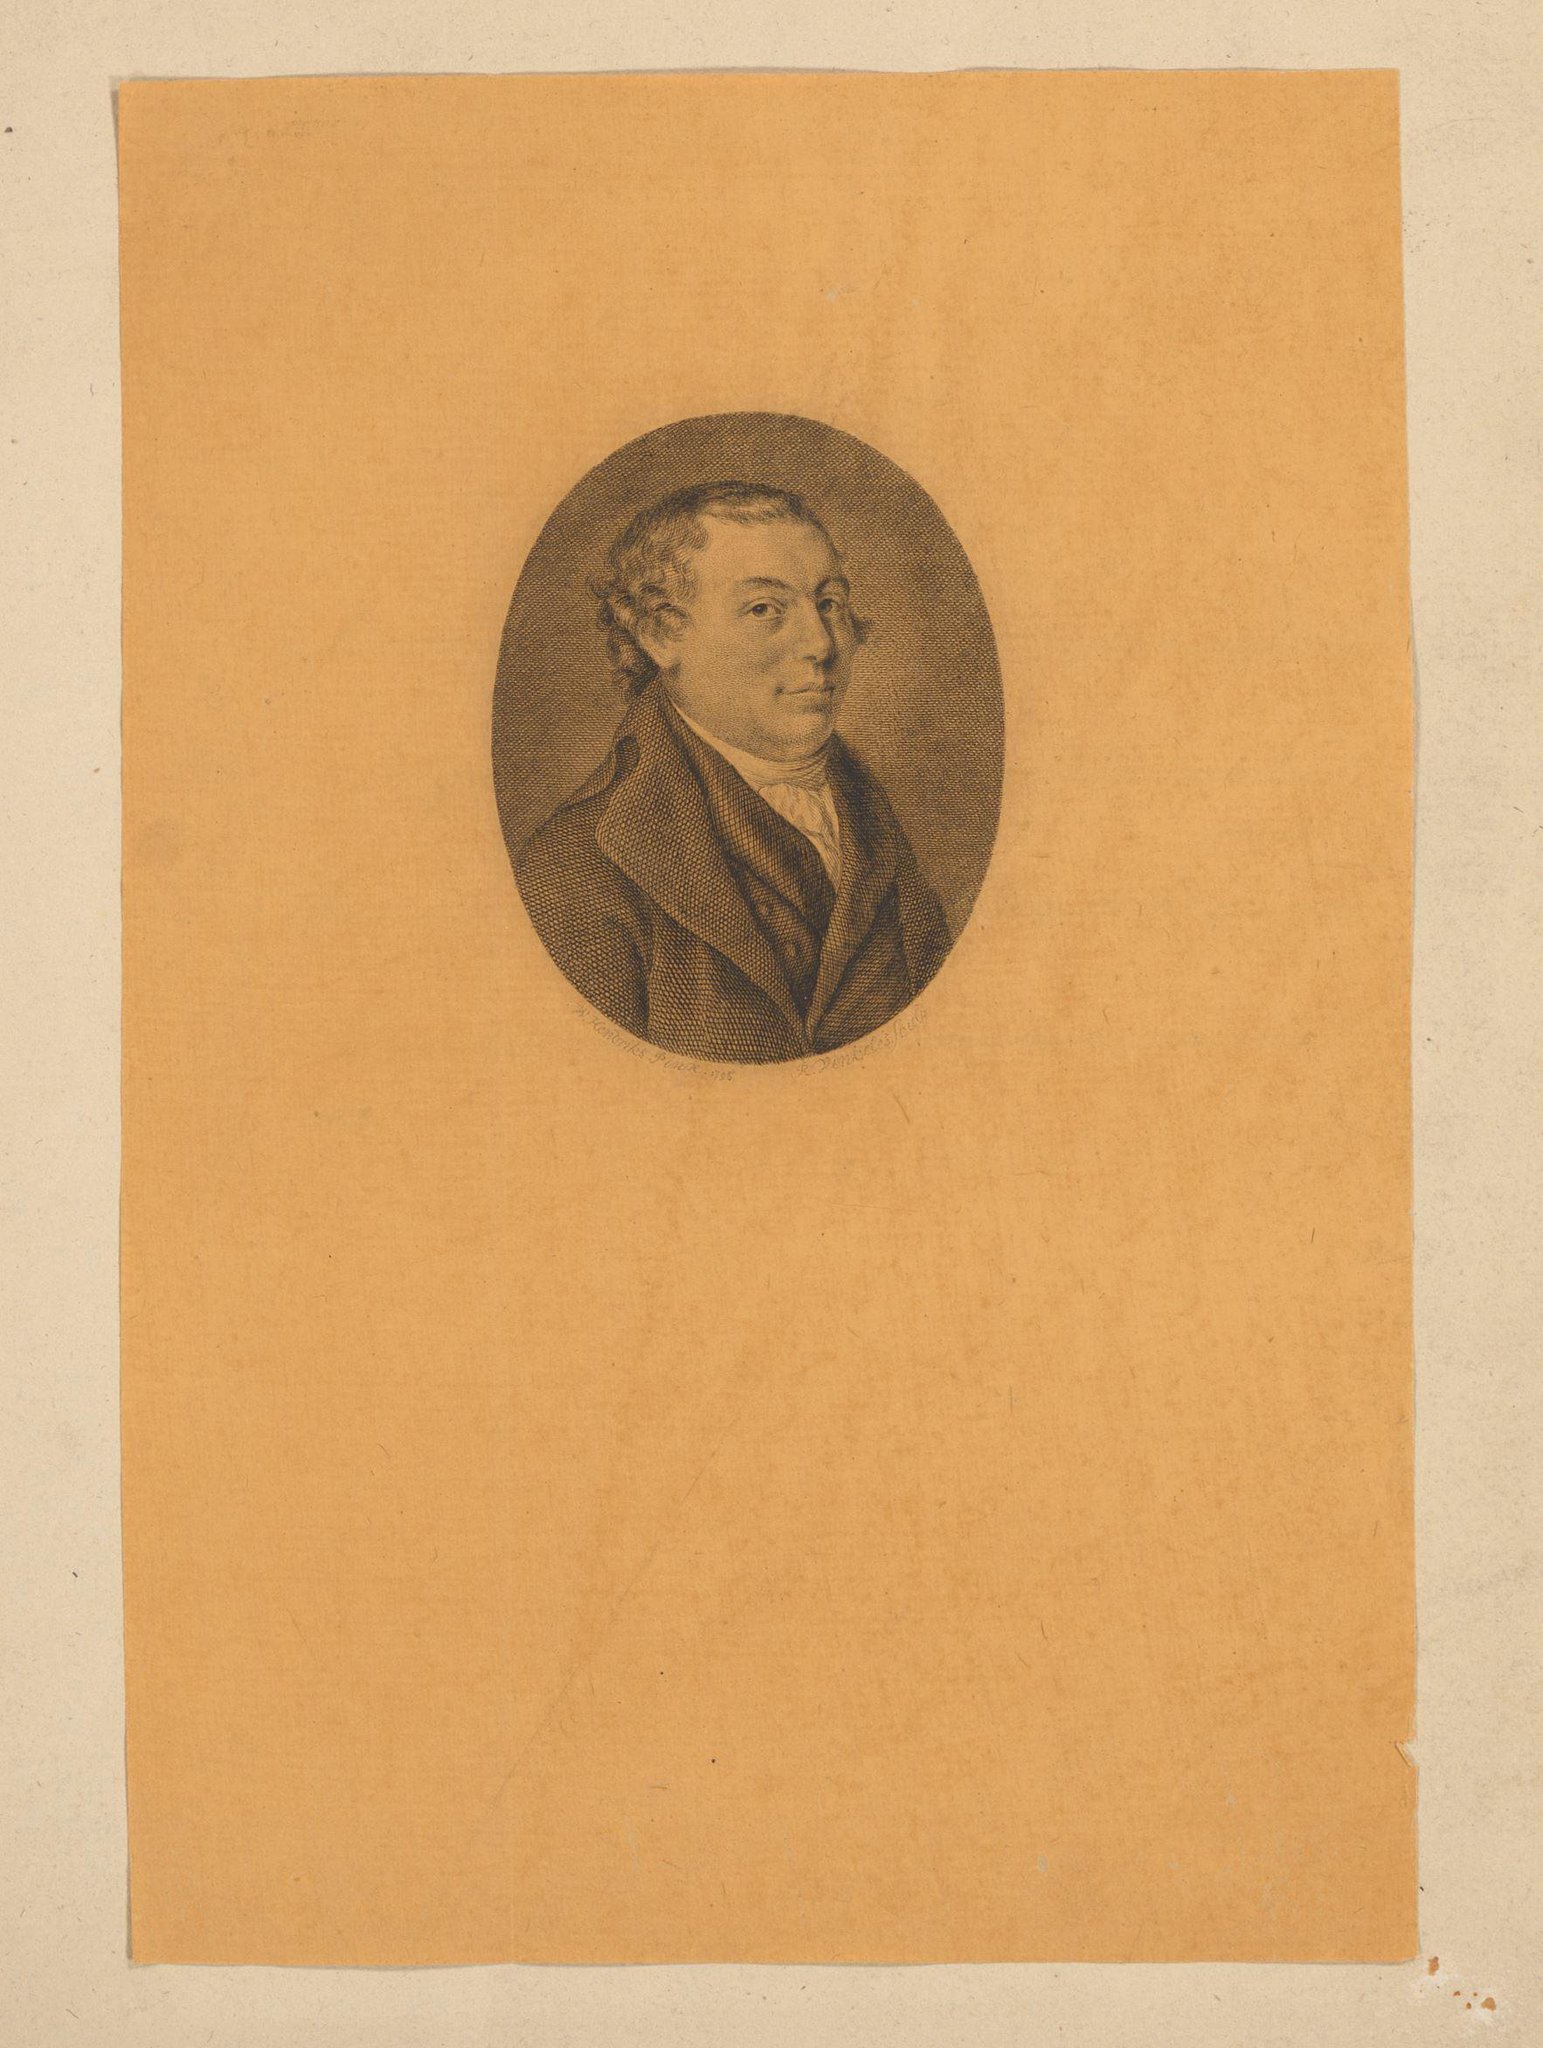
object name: album leaf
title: Portret van Adriaan Pietersz. Loosjes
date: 1796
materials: paper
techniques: engraving, etching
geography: amsterdam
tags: haarlem, publisher, bookseller, adriaan pietersz. loosjes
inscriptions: inscription: ‘Aanschouw, o mensch! ... of hooggeboren waarde / 1846’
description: Op een los blad bij deze voorstelling staat geschreven: Aanschouw, o mensch! dit beeld met eerbied en gevoel, / De geest, die God en Volk steeds stelde zich ten doel, / Heeft door zijn vlugge pen meer nut gesticht op aarde / Dan veler magt of schat, of hooggeboren waarde / 1846